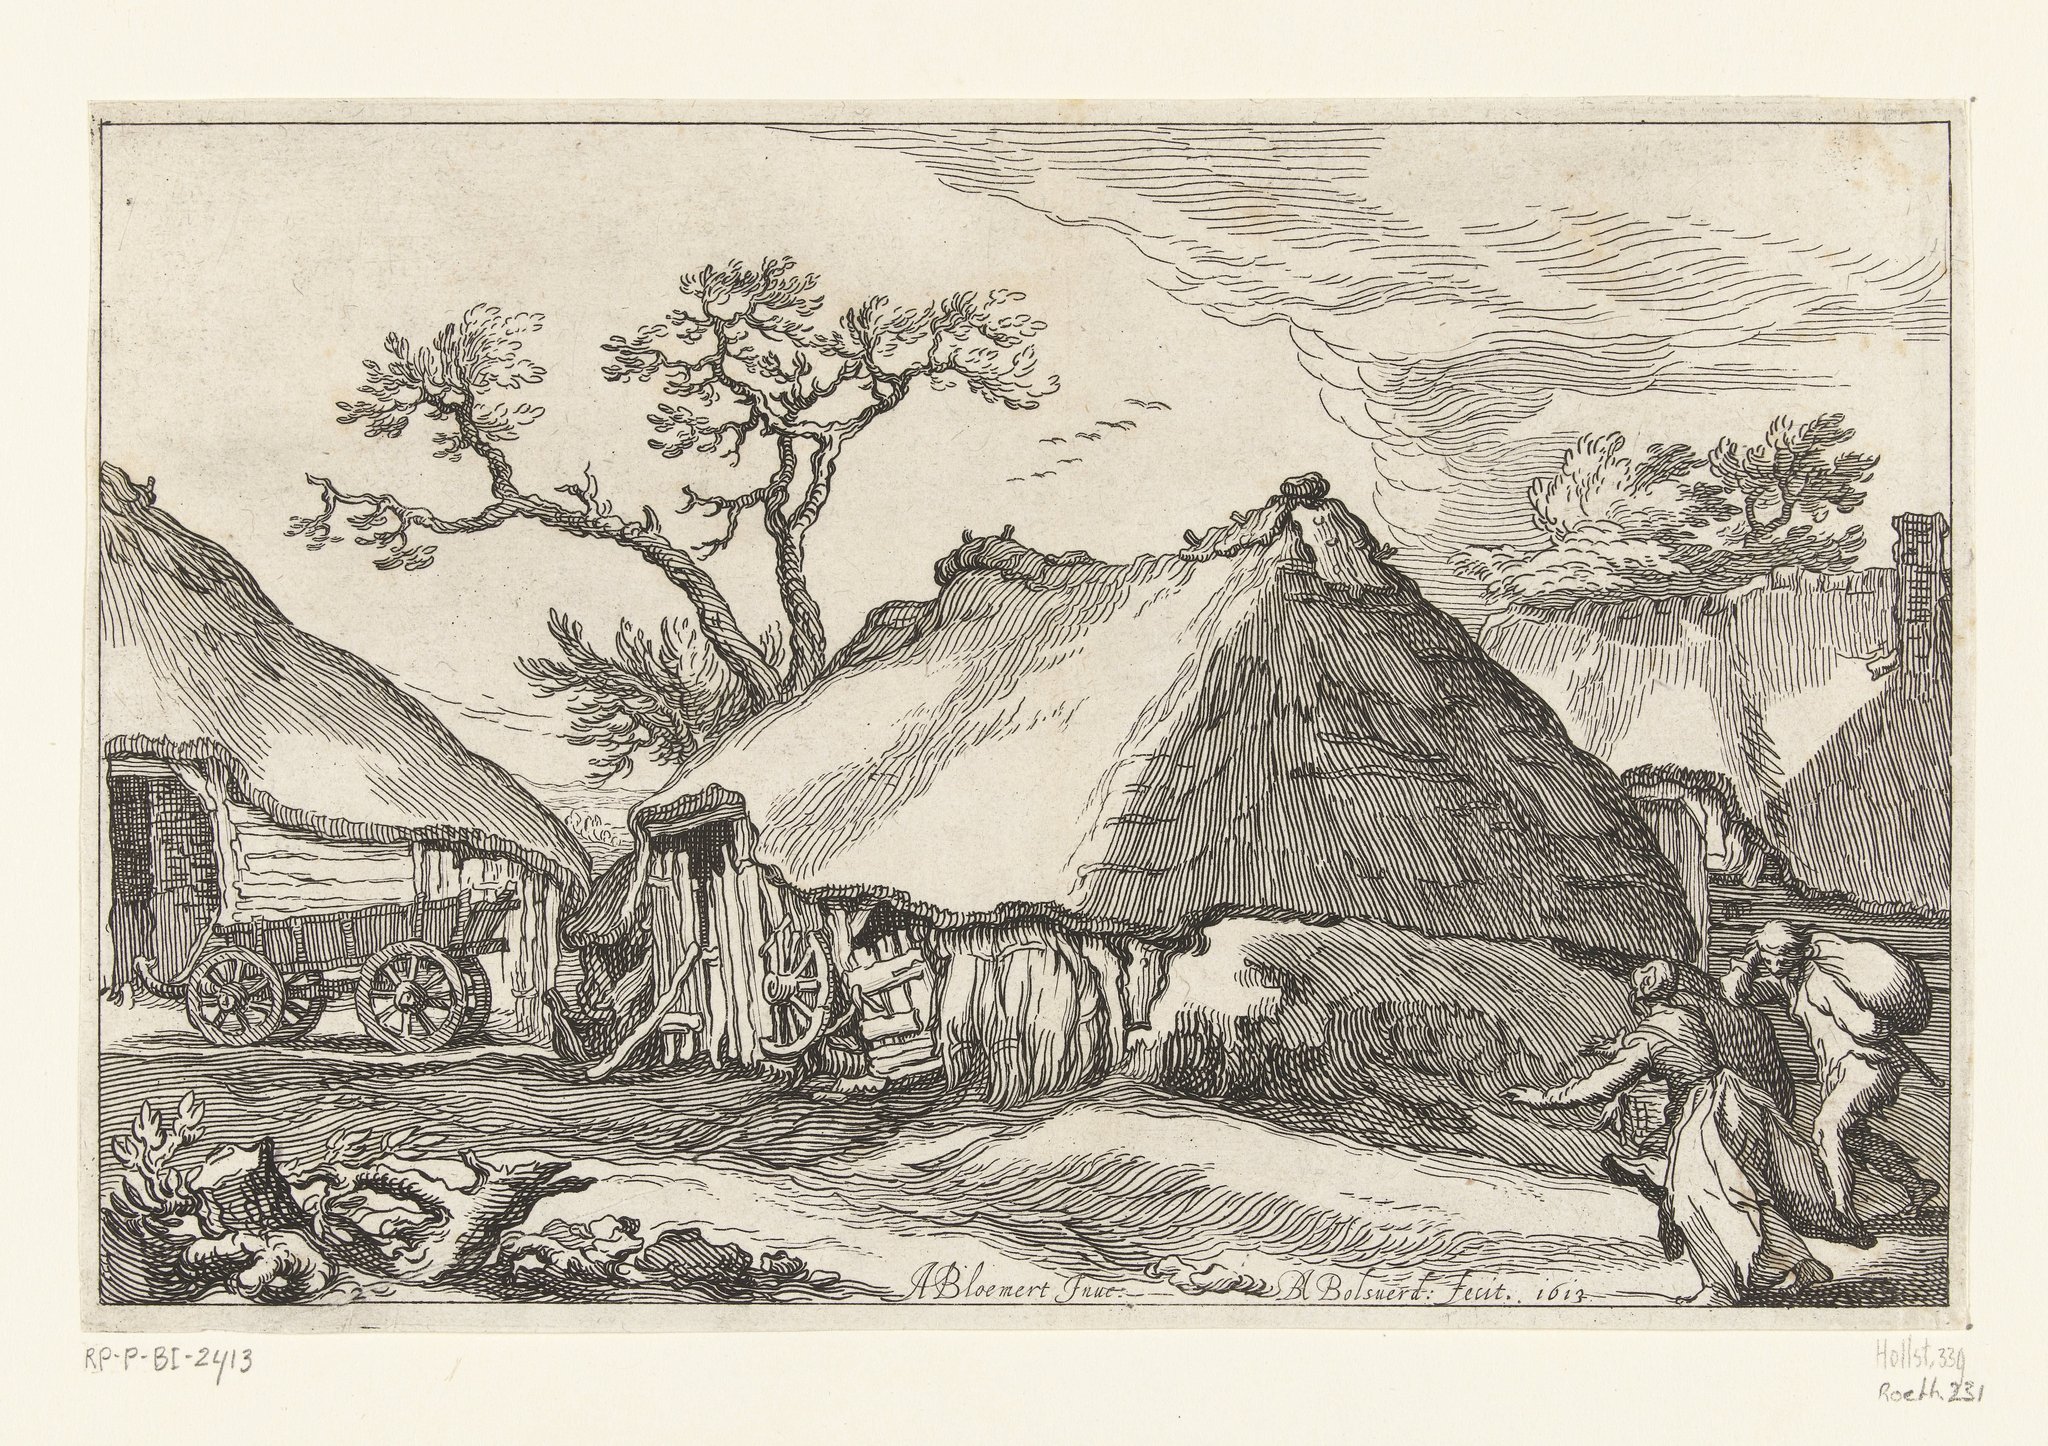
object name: print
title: Landschappen met boerderijen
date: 1613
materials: paper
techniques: etching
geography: amsterdam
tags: farm or solitary house in landscape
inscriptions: collector's mark: Lugt 240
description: Prent uit serie van twintig Landschappen met boerderijen naar ontwerp van Abraham Bloemaert.